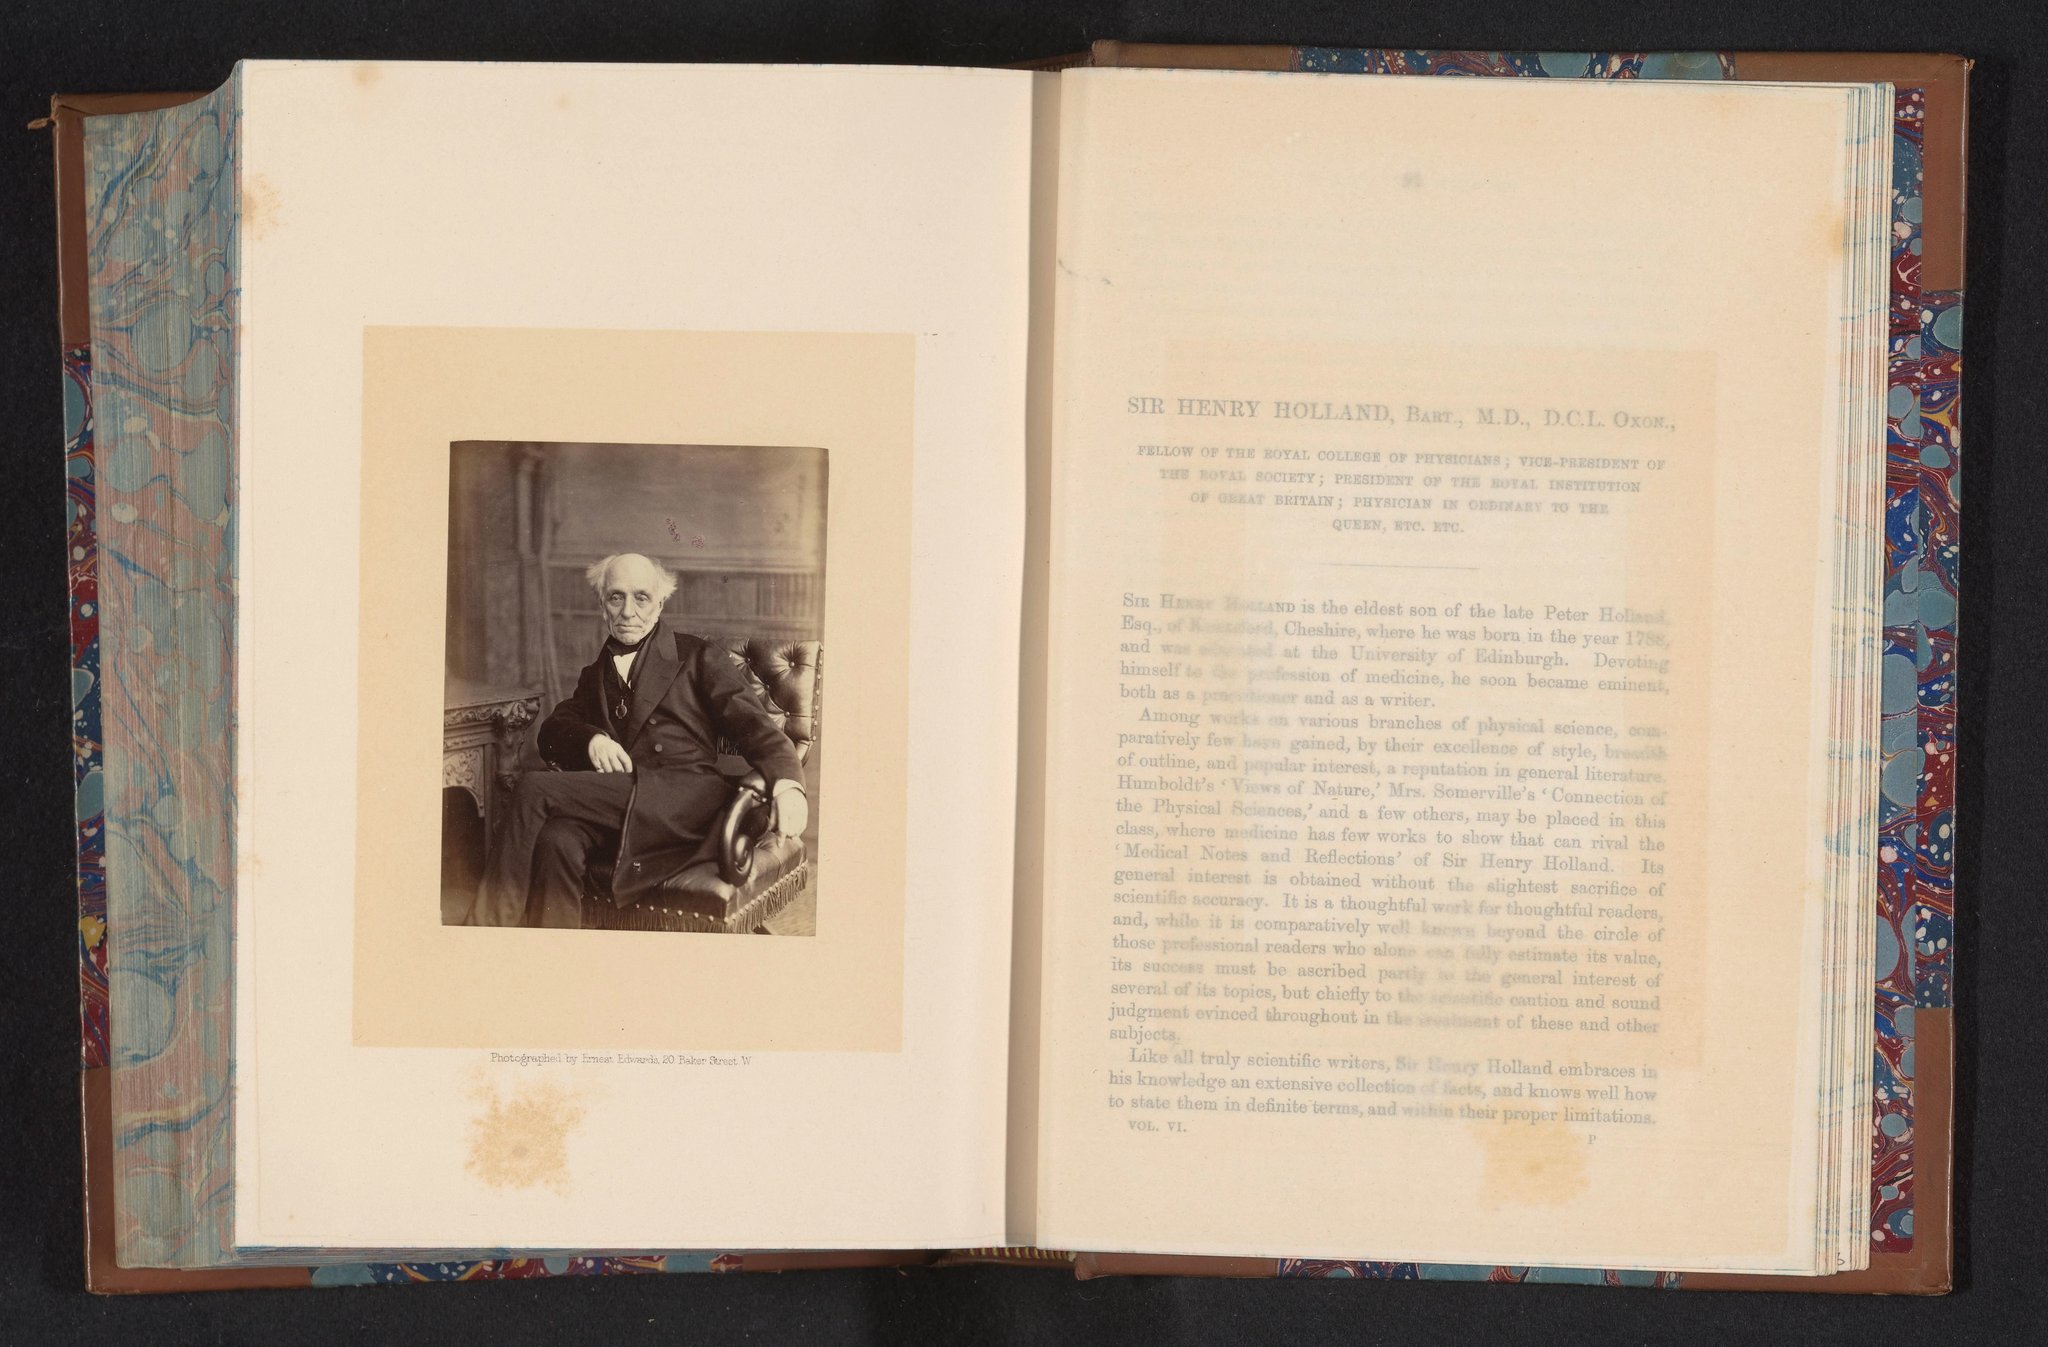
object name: page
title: Portret van Sir Henry Holland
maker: ernest edwards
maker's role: fotograaf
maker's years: 1837-1903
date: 1853-1867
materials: photographic support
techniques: albumen print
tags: physician, doctor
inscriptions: name: ‘Photographed by Ernest Edwards, 20, Baker Street. W.’